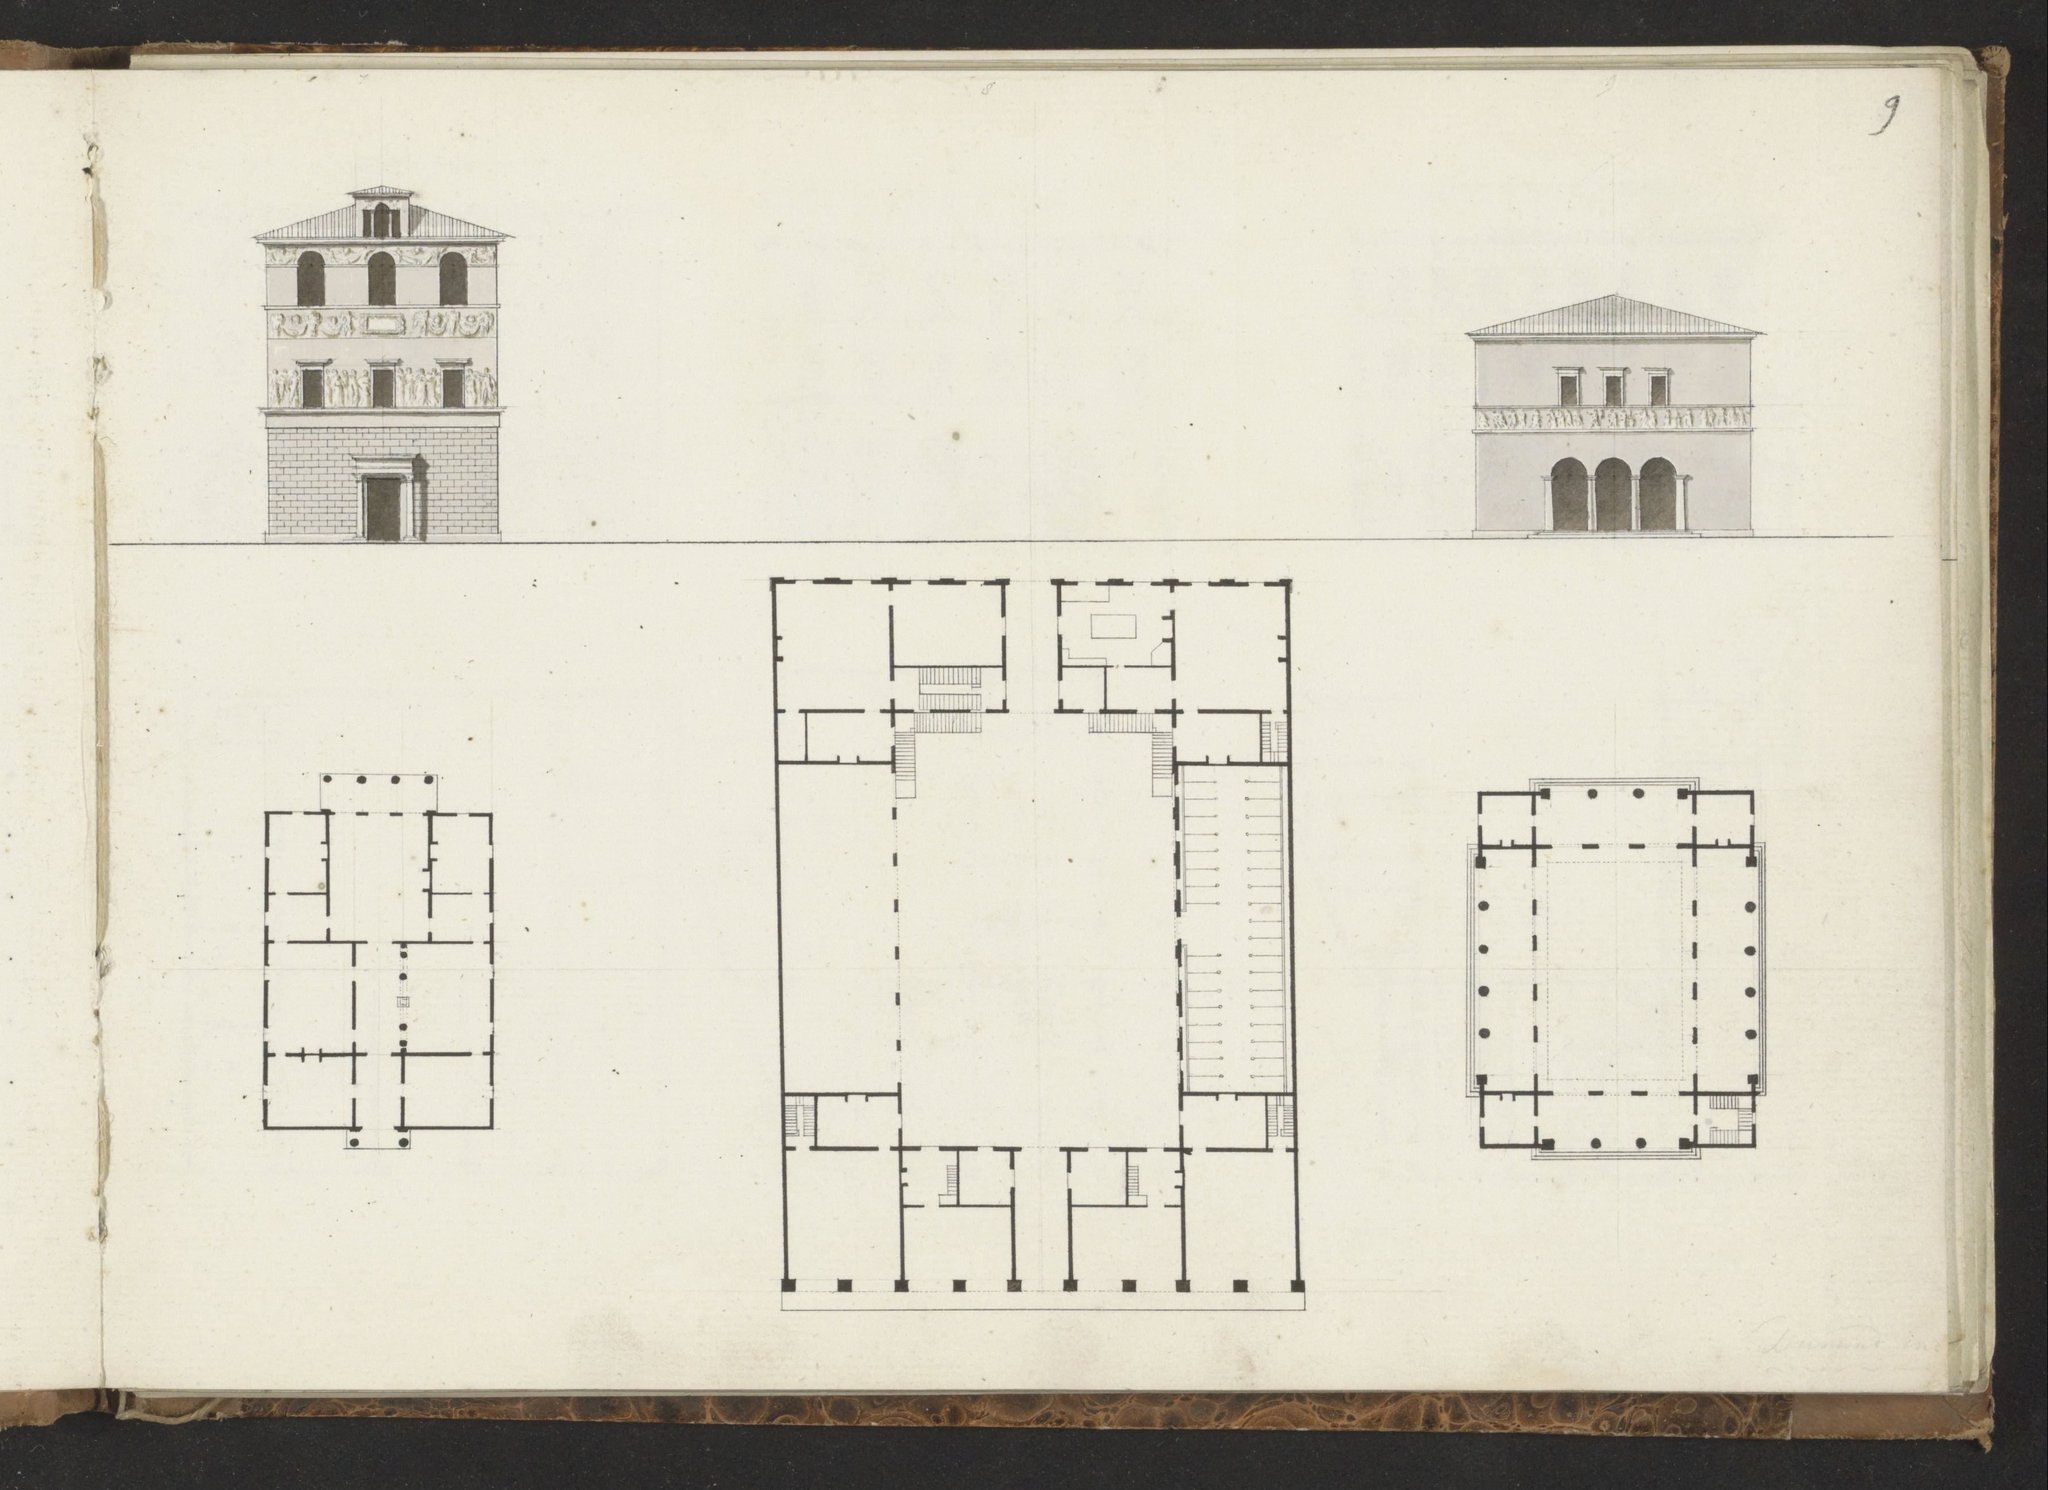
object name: sketchbook leaf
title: Plattegronden en voorgevels van twee villa's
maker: willem springer jr.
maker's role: draughtsman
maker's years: 1815-1907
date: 1825-1907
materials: ink, paper, pencil, watercolor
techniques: brush, pen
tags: villa, façade (of house or building), plan ~ architecture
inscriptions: annotation: ‘D[...]d ind.’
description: Pagina 9 uit een schetsboek met 86 pagina's.